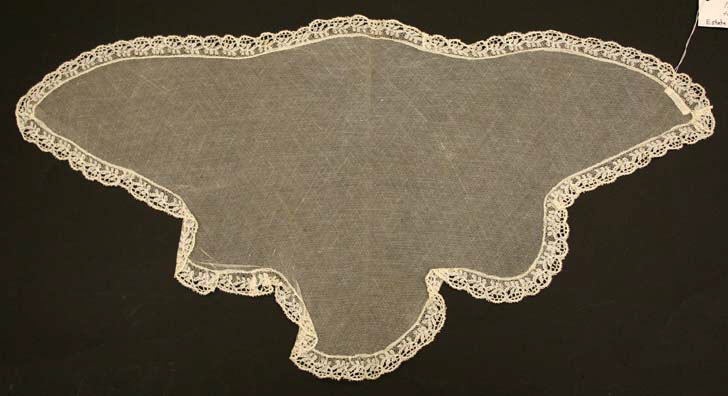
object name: neckpiece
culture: american or european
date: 1700-1945